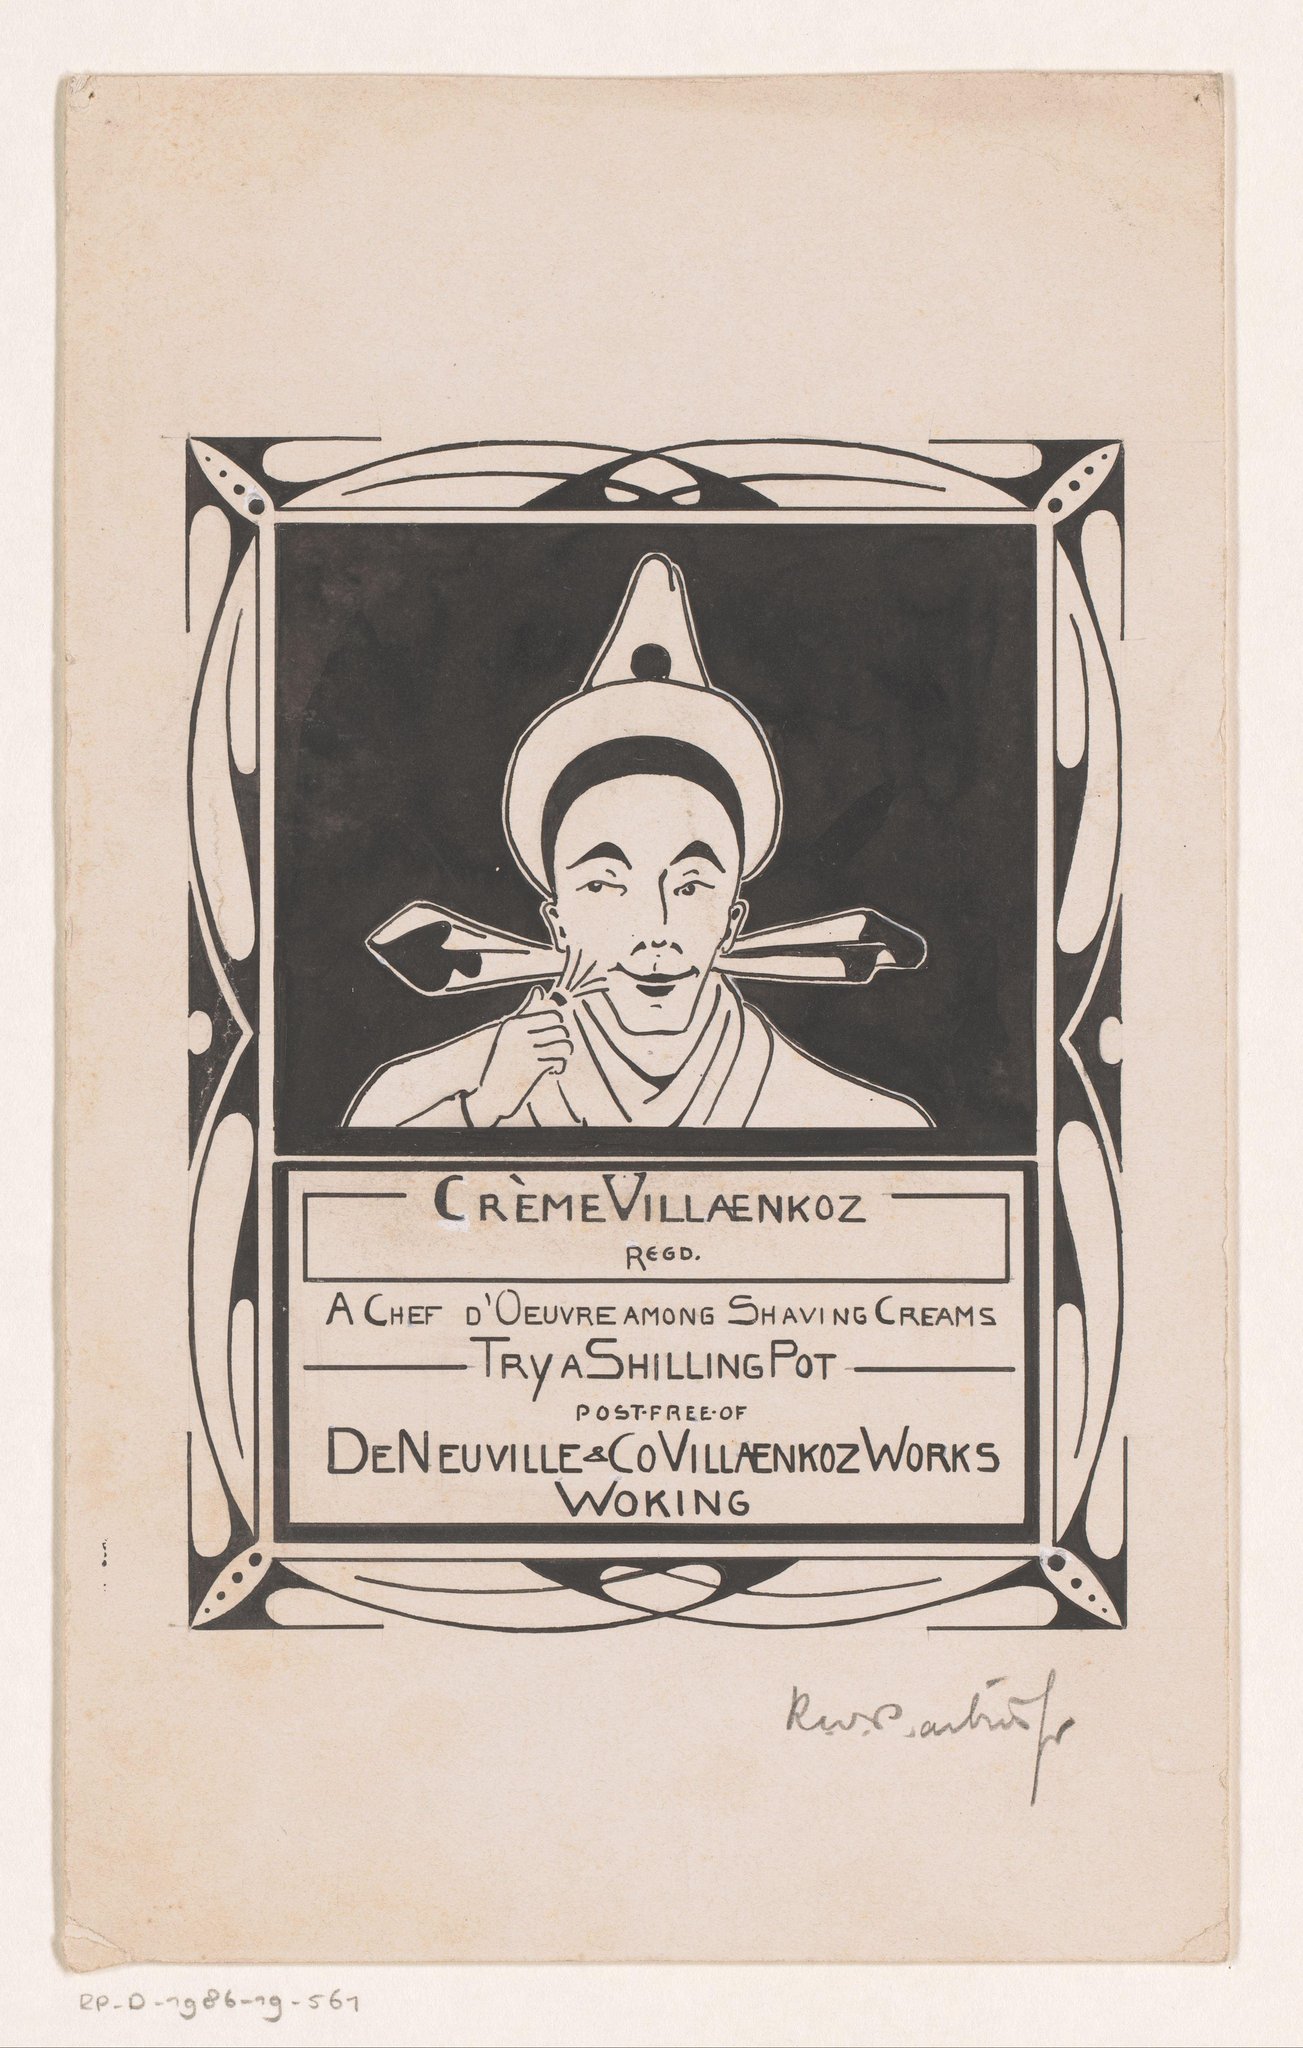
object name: drawing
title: Ontwerp voor een advertentie van Crème Villaenkoz scheerschuim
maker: reinier willem petrus de vries (1874-1953)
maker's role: draughtsman, print maker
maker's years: 1874-1953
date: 1884-1952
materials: paint, ink, paper, pencil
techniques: brush, pen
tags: care of the body, hygiene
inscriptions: collector's mark: ‘R:MVS.’, address: ‘R.W.P. de Vries Jr./ Warmoesstraat 122/ Amsterdam/ Holland’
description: Een man met een hoed smeert met een kwast scheerschuim op zijn gezicht.